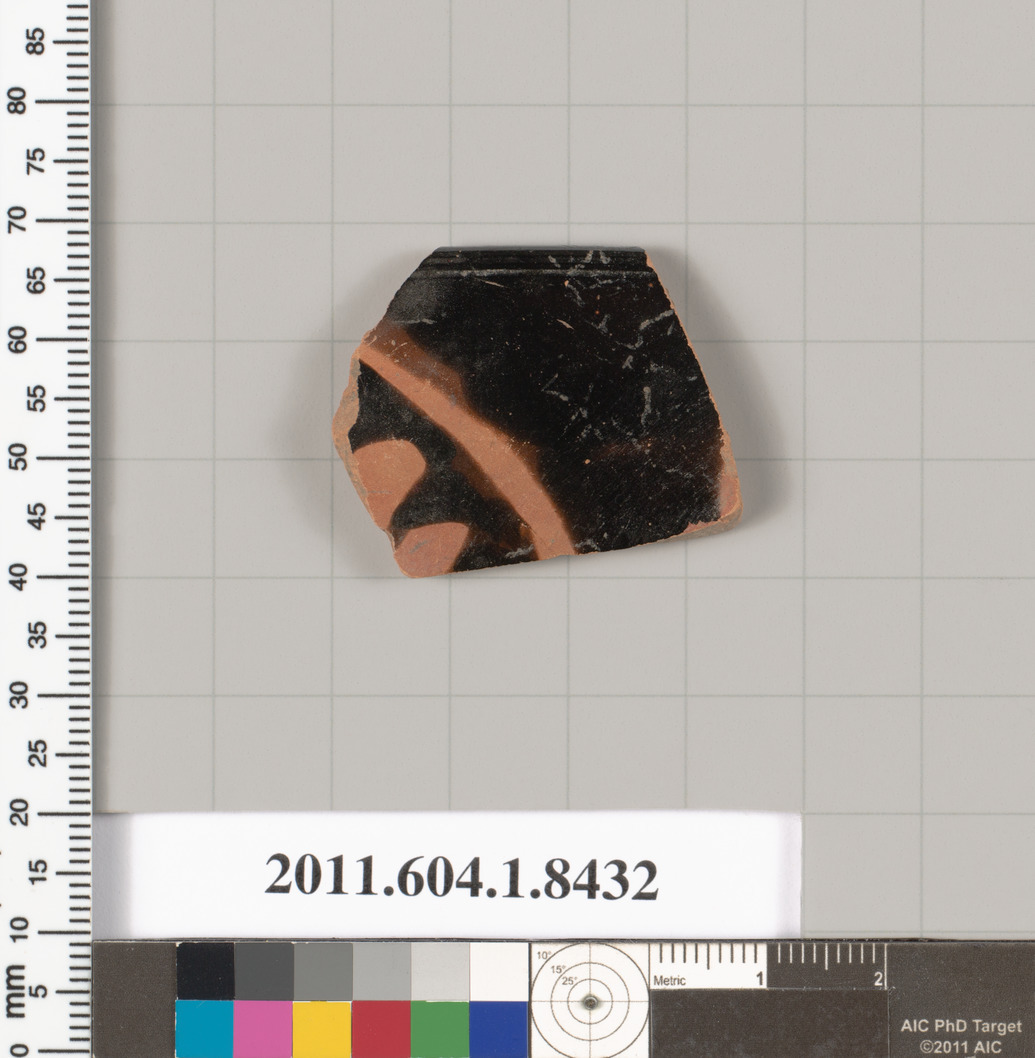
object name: kylix fragment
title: Terracotta rim fragment of a kylix (drinking cup)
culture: greek, attic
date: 400-351 BCE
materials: terracotta